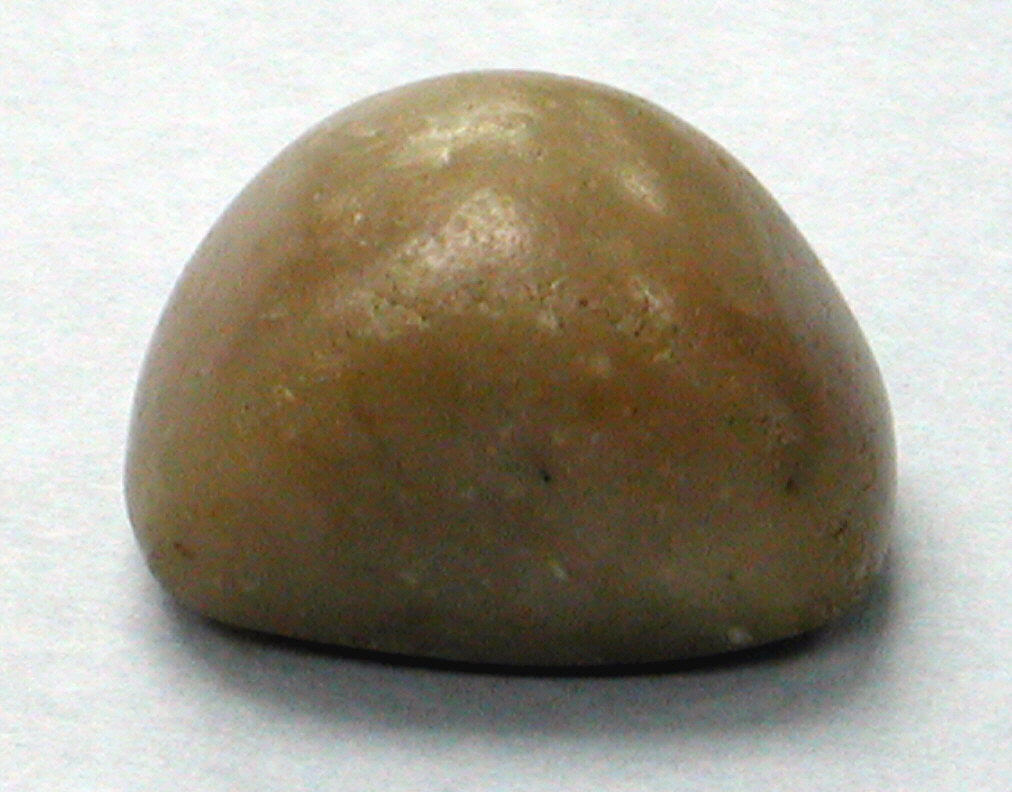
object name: ritual stone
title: Stone Pulidor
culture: mexican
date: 1501-1600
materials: stone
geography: mexico